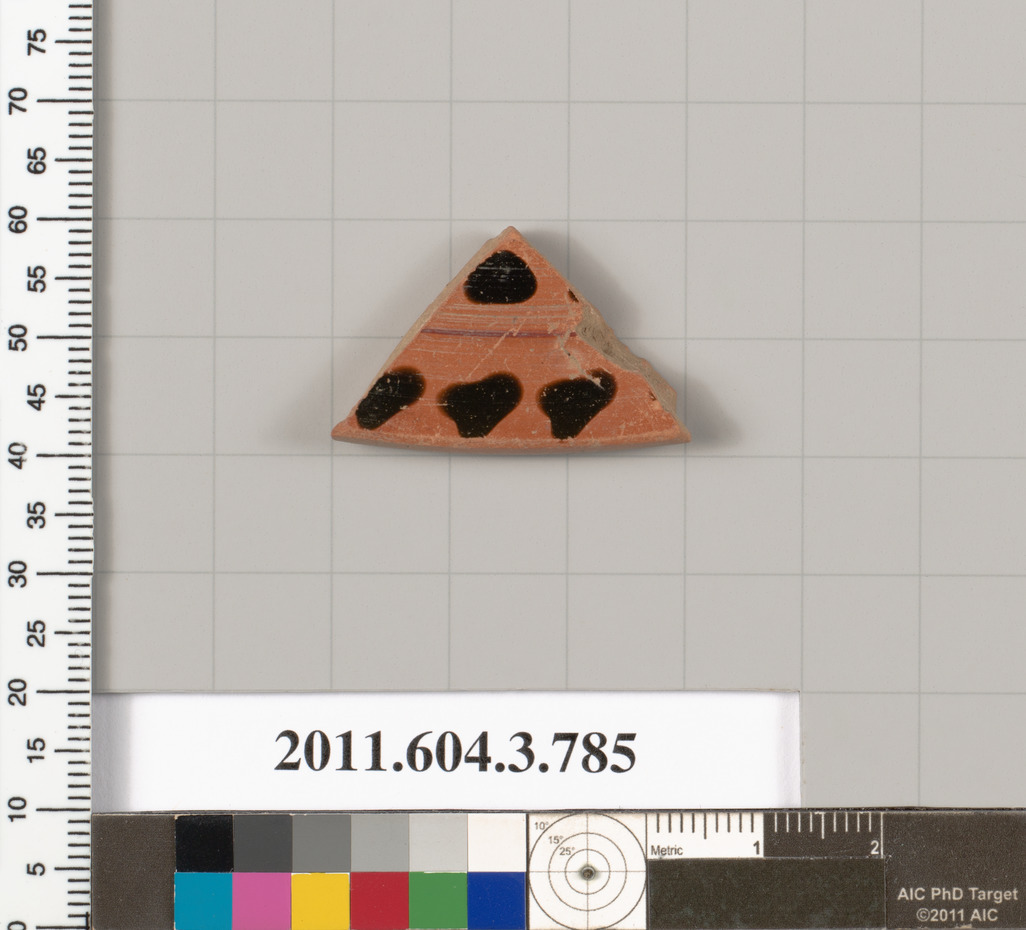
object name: lid fragment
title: Terracotta fragment of a lid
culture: greek, attic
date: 600-501 BCE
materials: terracotta